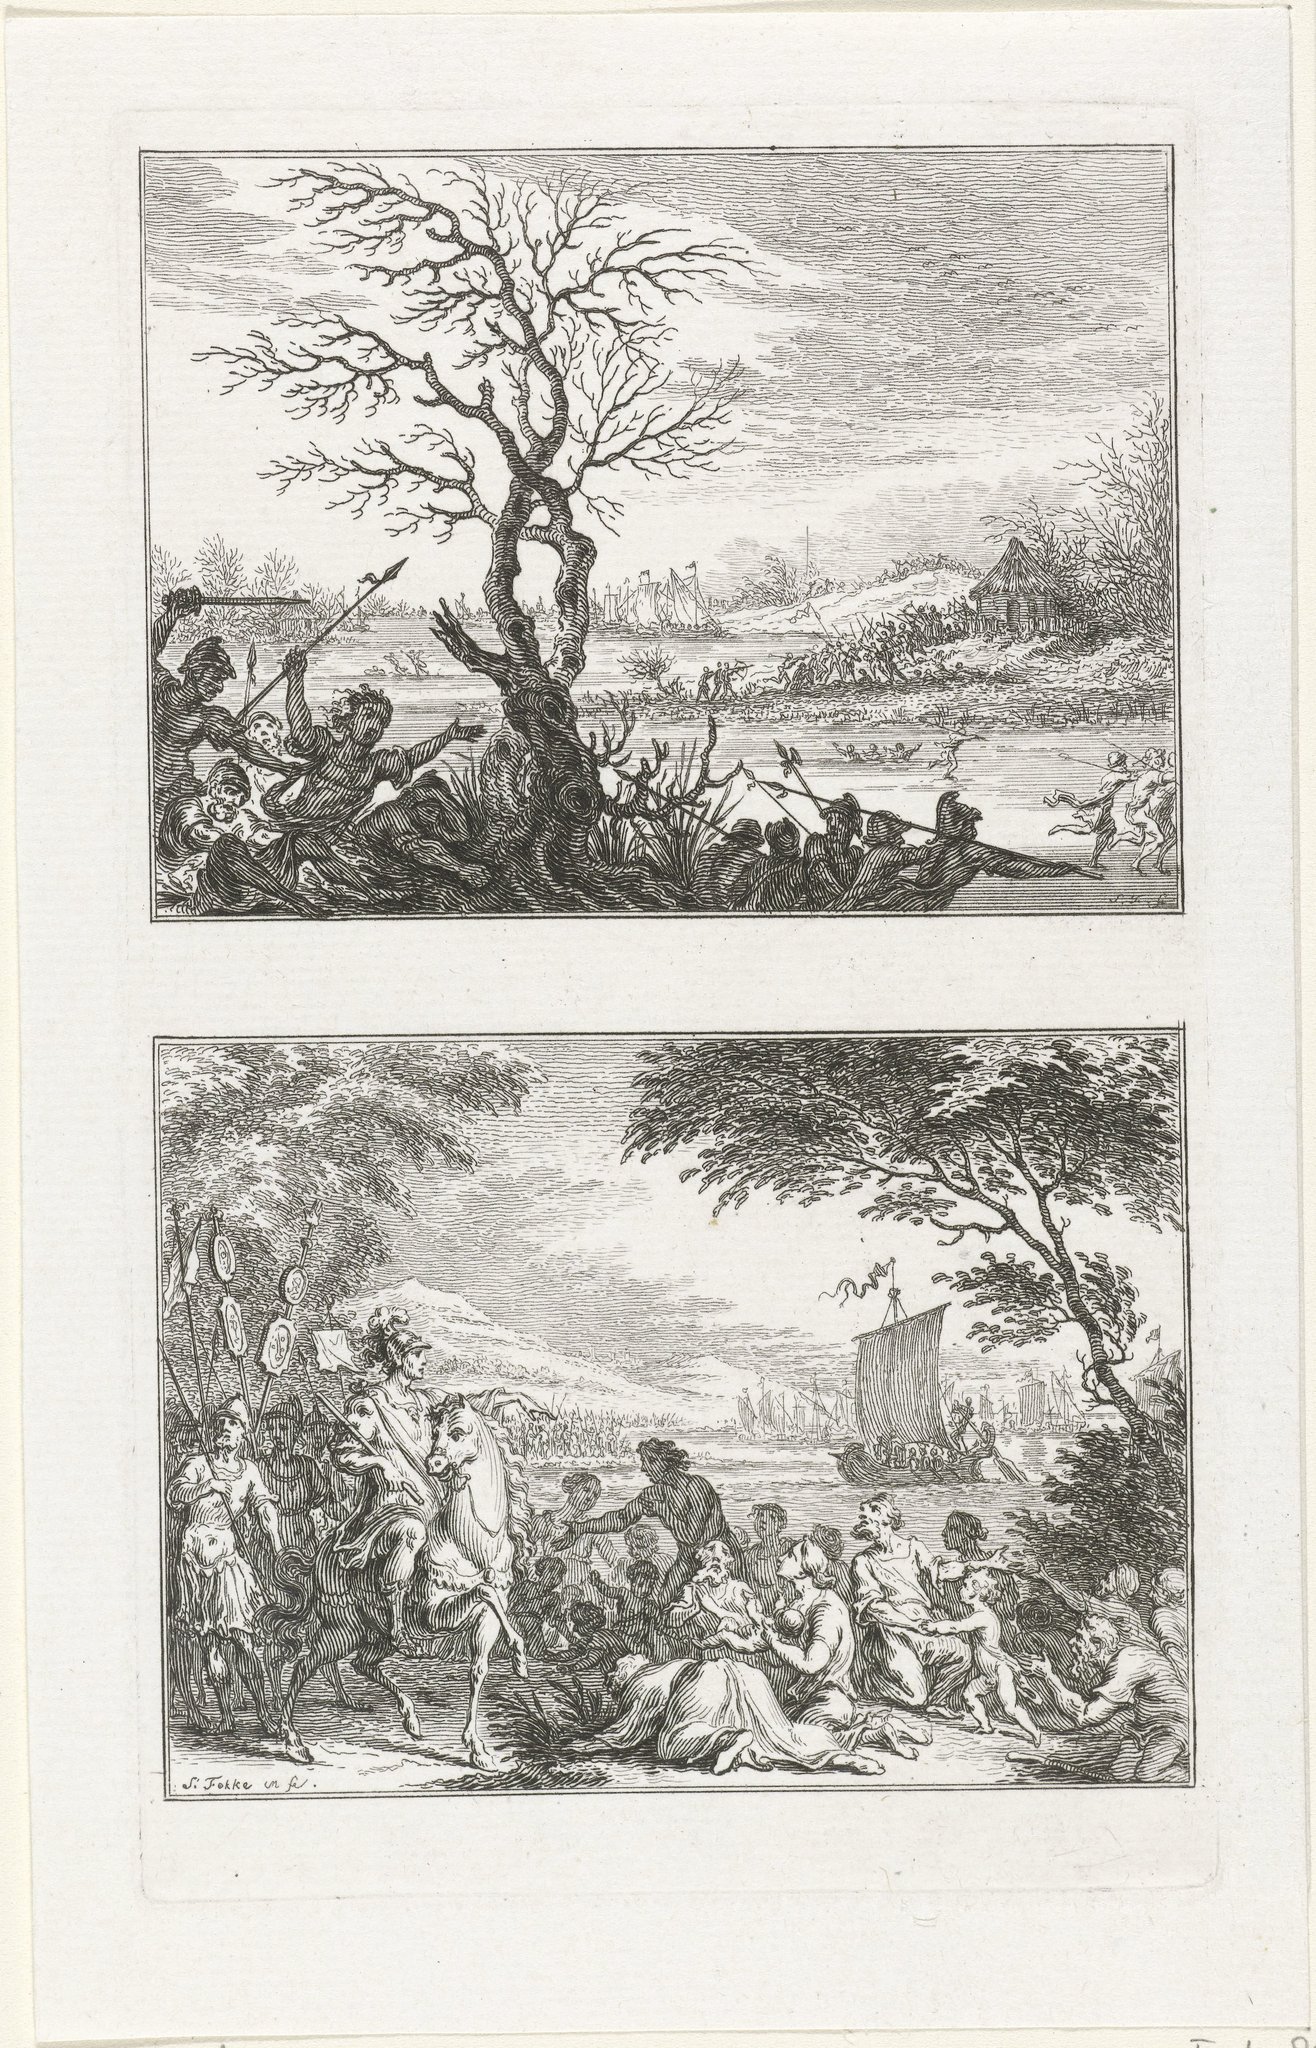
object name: print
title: De Franken vallen het land van de Bataven binnen, 253, en onderwerping van de Saliërs aan Juliaan, 358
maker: simon fokke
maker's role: draughtsman, print maker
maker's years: 1712-1784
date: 1784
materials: paper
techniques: etching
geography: amsterdam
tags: battle, fighting in general, surrender ~ war, extinct, 'historical' peoples (with name)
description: Voorstellingen uit de vaderlandse geschiedenis. Boven: Franken vallen gewapend met speren en zwaarden het land van de Bataven binnen. Onder: De Salische Franken onderwerpen zich aan de op een paard gezeten Romeinse opperbevelhebber Flavius Claudius Julianus. Twee voorstellingen van één plaat.